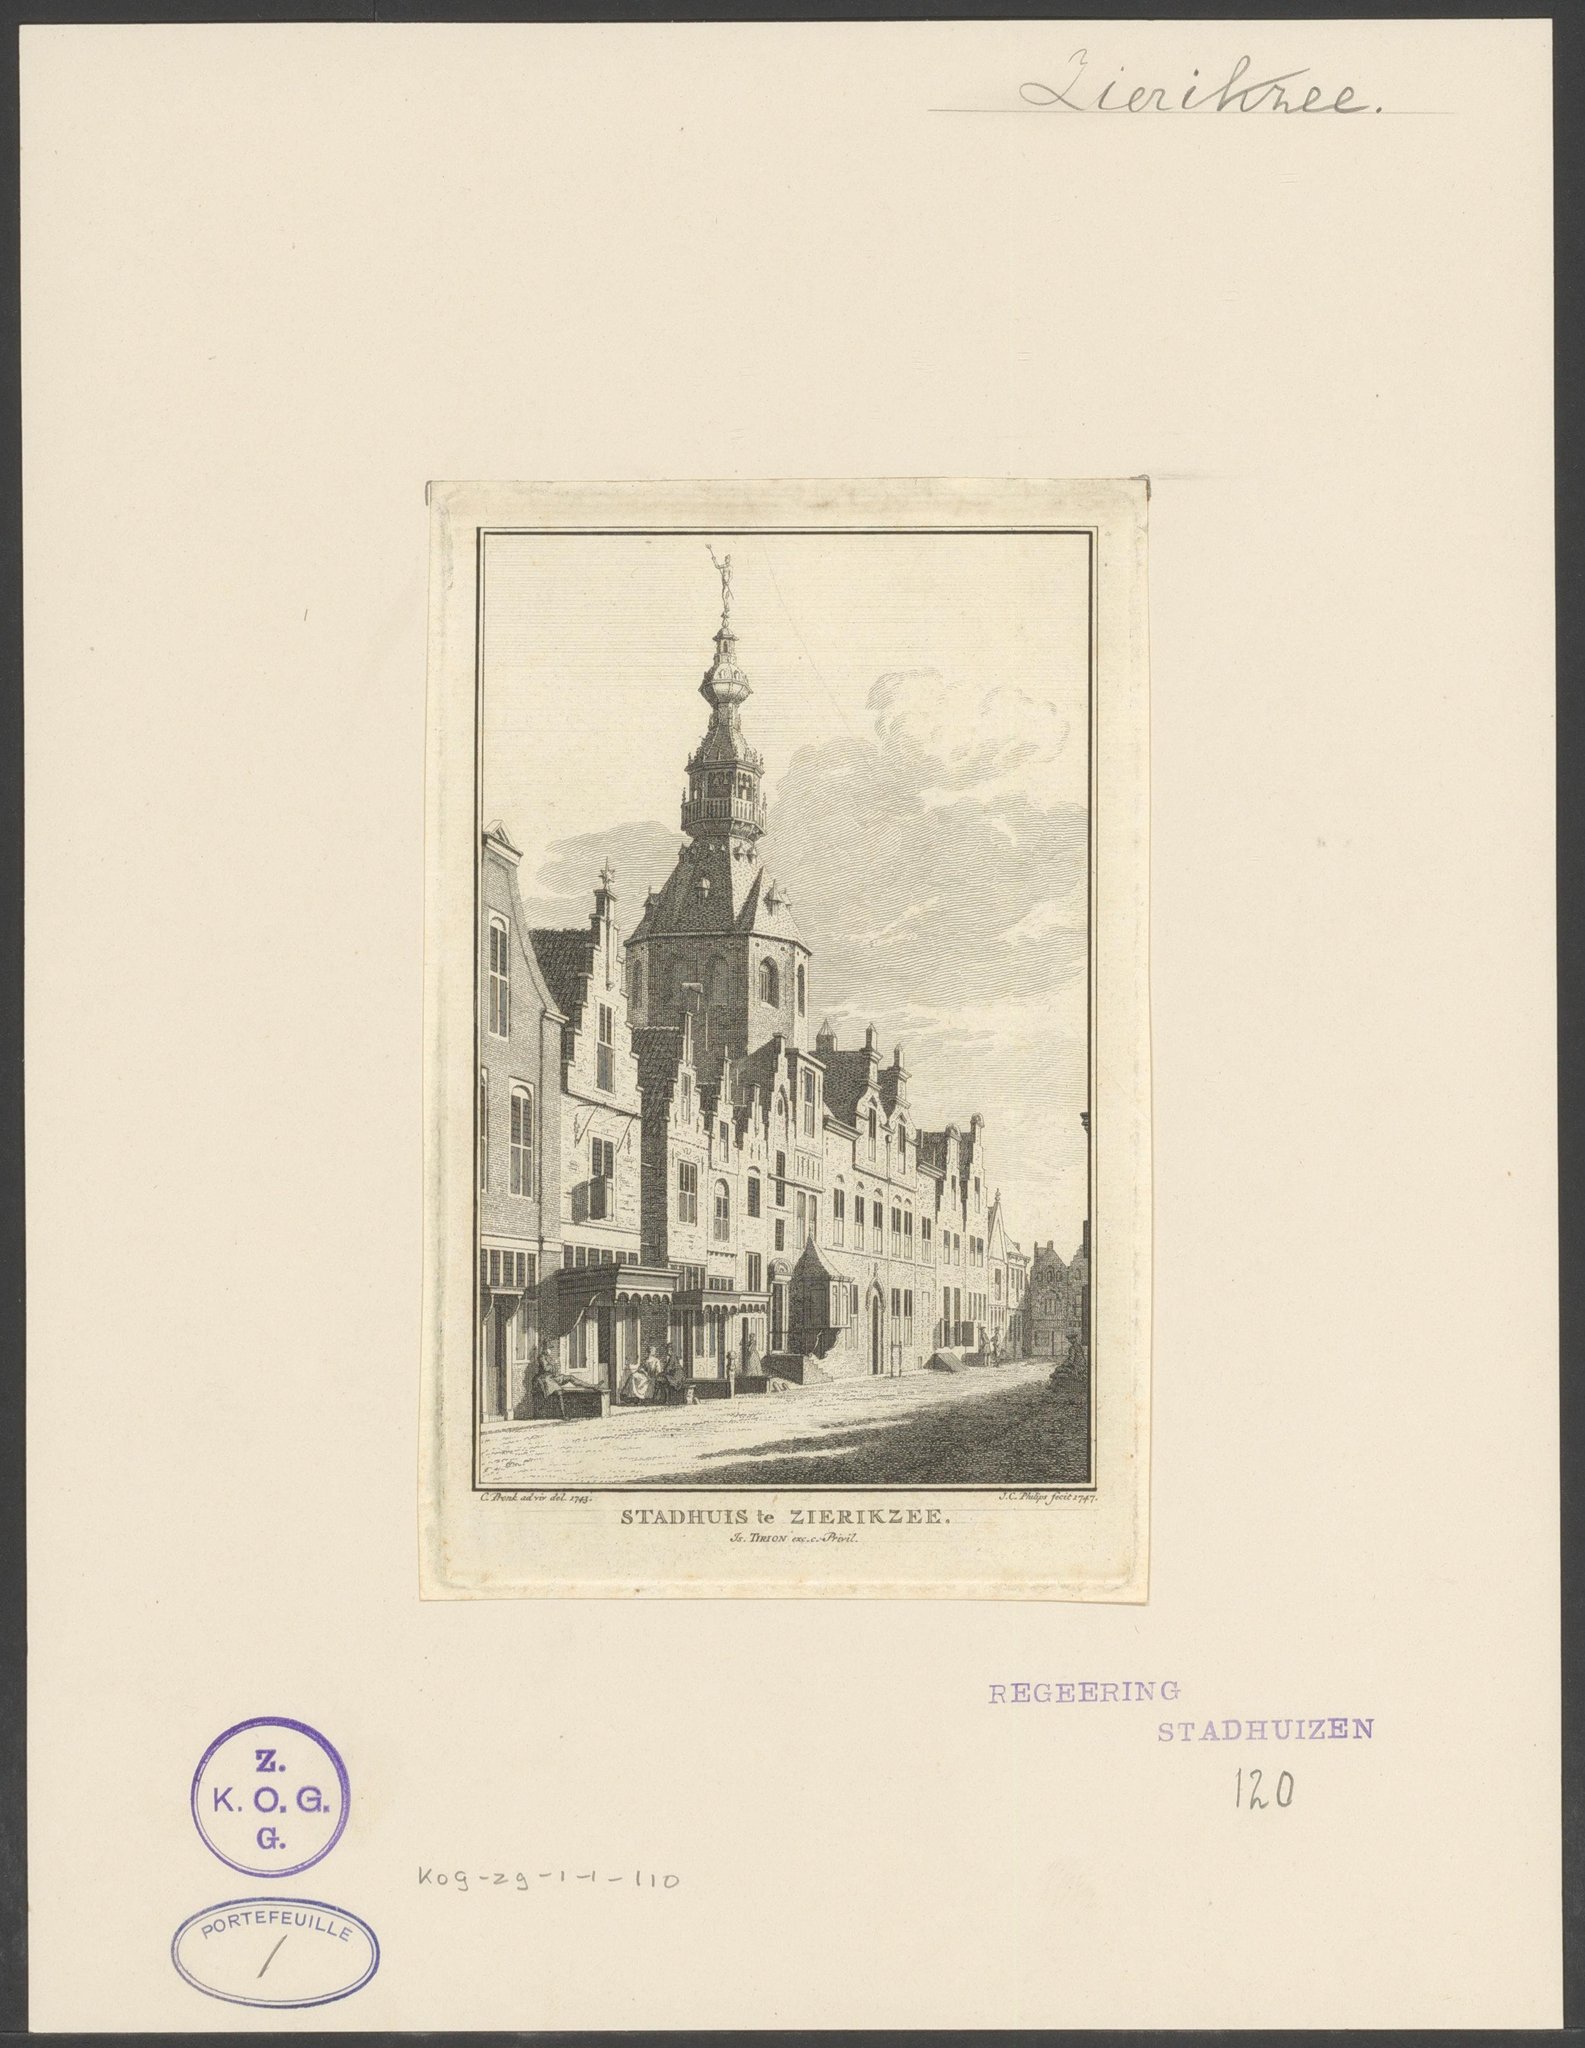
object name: print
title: Stadhuis te Zierikzee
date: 1747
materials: paper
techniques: engraving, etching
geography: ijsselstein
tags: townhall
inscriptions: collector's mark: Lugt 1641, collector's mark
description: Gezicht op het stadhuis van Zierikzee, gelegen in de Meelstraat, in de situatie omstreeks 1743. Onderwerpsrubrieken binnen de Atlas Zeden en Gewoonten: Regeering, Stadhuizen (T-Z).